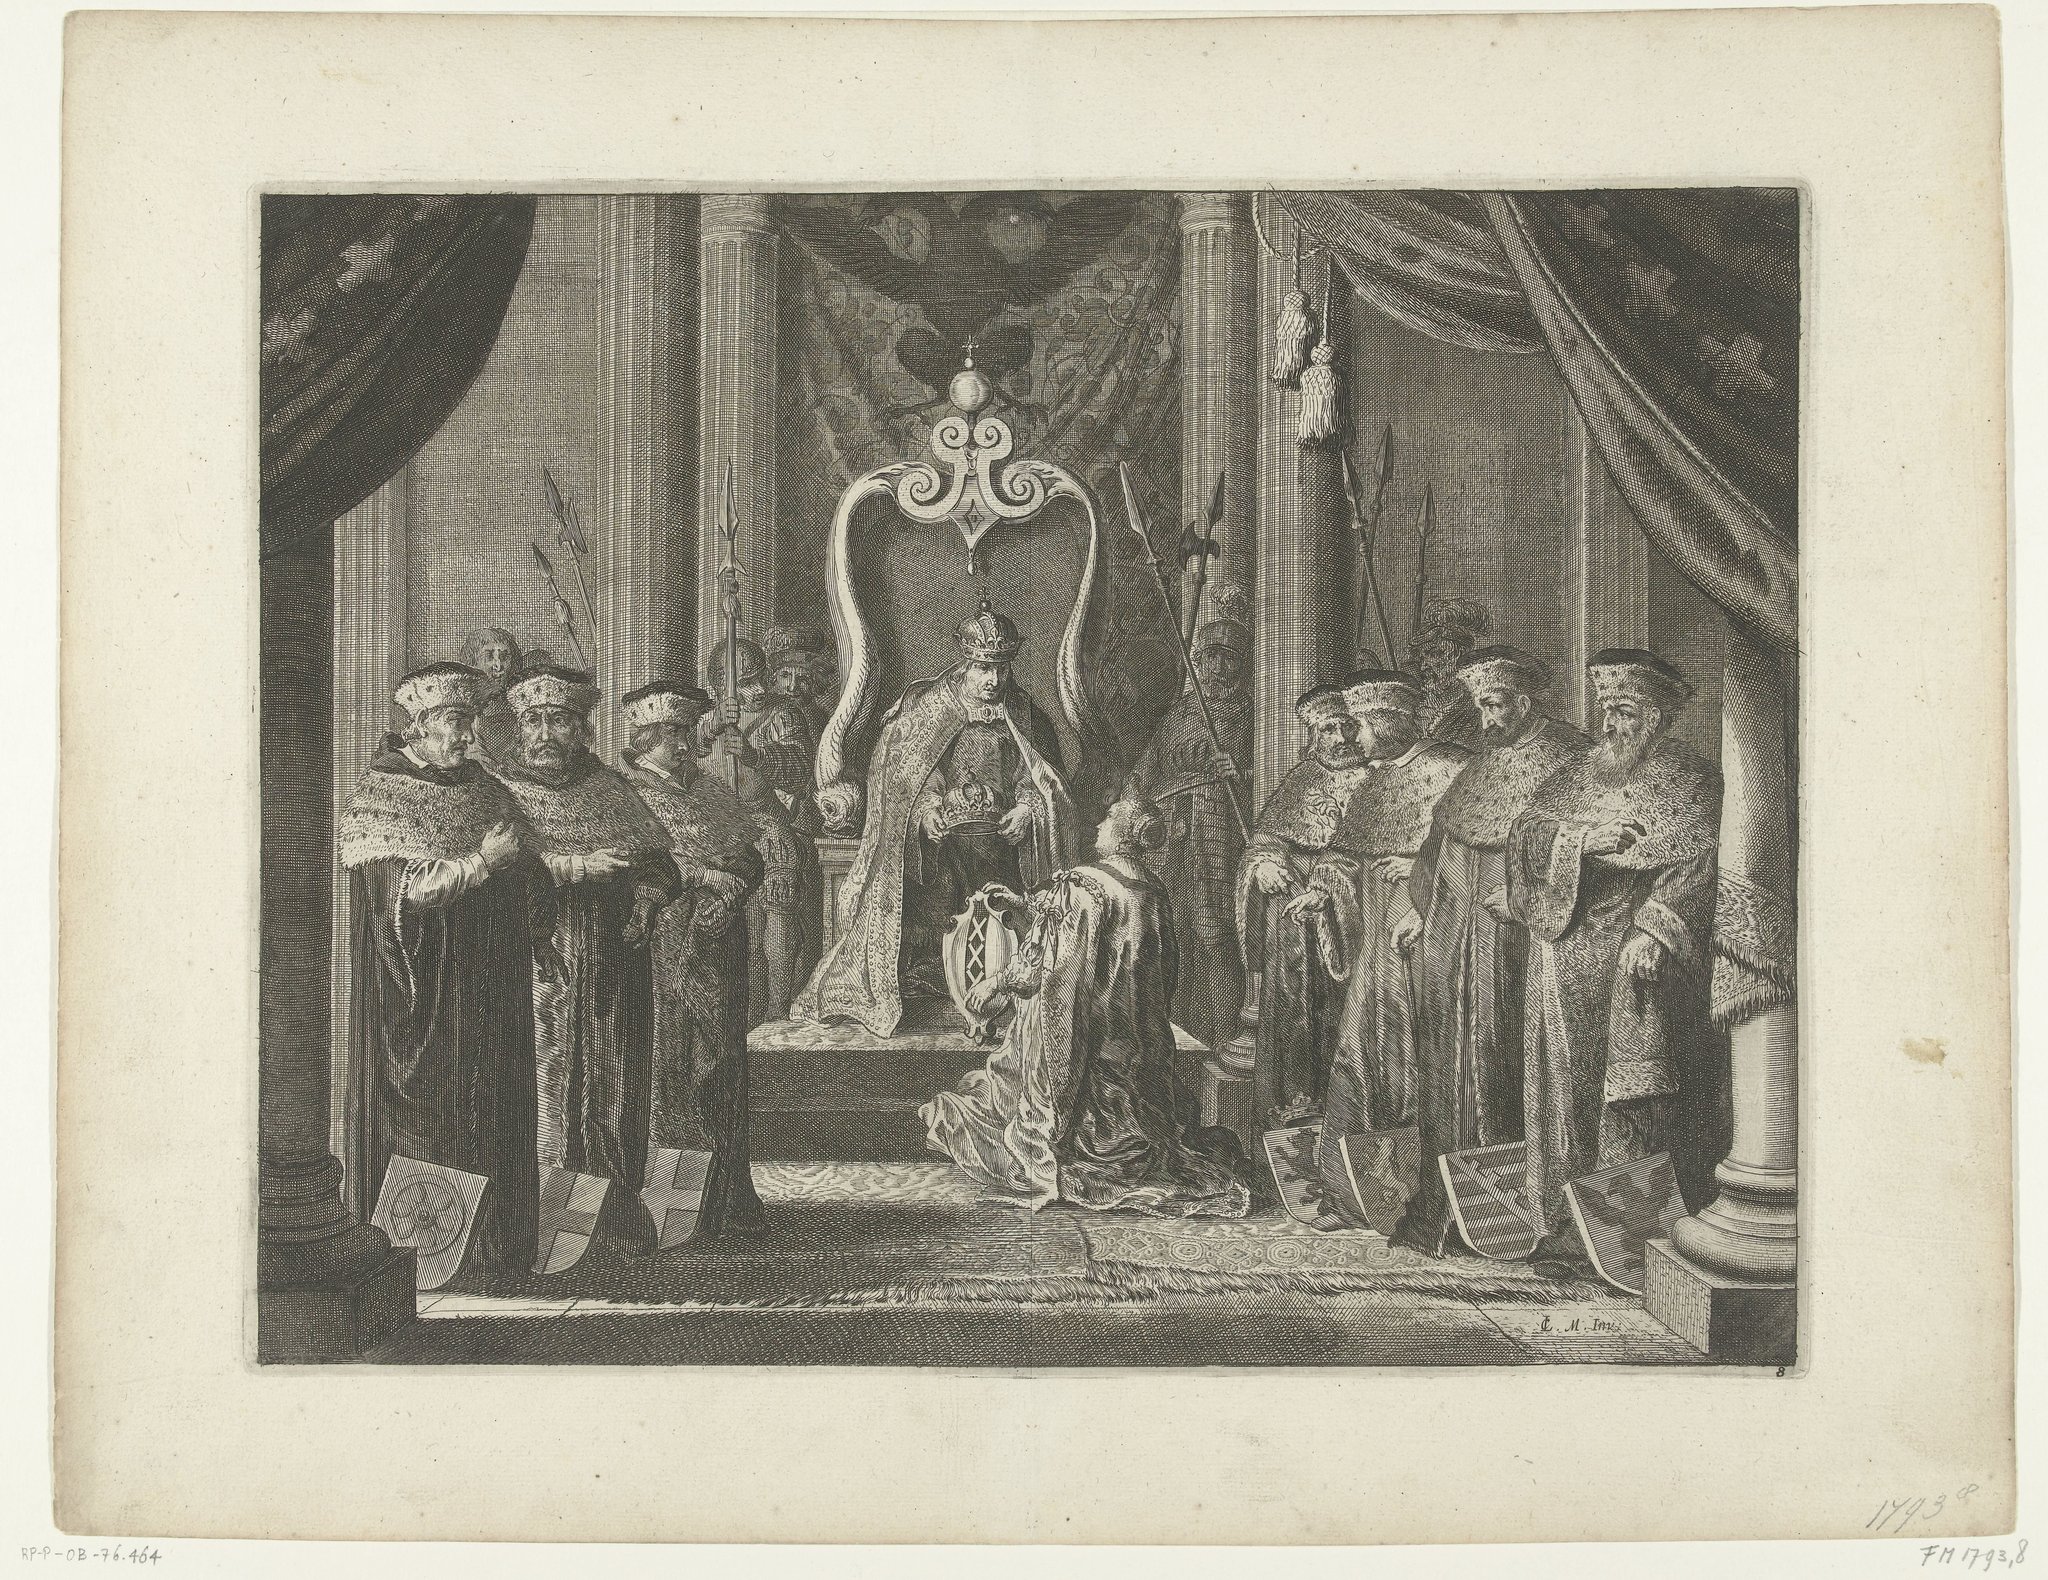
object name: book illustration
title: Keizer Maximiliaan I verleent de keizerskroon aan Amsterdam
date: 1638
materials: paper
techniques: engraving, etching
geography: amsterdam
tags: cologne, maria de' medici, maximilian i (holy roman emperor), 'tableau vivant', personification of a city, town-patron(ess), triumphal entry and public reception, pageant, 'entrée solennelle', 'joyeuse entrée', amsterdam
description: Prent ook gebruikt in:* Baerle, Caspar van. Medicea hospes, sive descriptio publicae gratulationis, qua Serenissimam, Augustissimamque Reginam, Mariam de Medicis (…). Amsterdam: Johannes en Cornelis Willemsz. Blaeu, 1638. En in: Baerle, Caspar van. Marie de Medicis, entrant dans Amsterdam : ou, histoire de la reception faicte à la Reyne Mere du Roy tres-Chrestien (…). Amsterdam: Johannes en Cornelis Willemsz. Blaeu, 1638. En in: Baerle, Caspar van en Joost van den Vondel. Blyde inkomst der allerdoorluchtighste koninginne, Maria de Medicis t' Amsterdam. Vertaelt uit het Latijn (…). Amsterdam: Johannes en Cornelis Willemsz. Blaeu, 1639. * Doorgaans zijn de prenten in de bovengenoemde publicaties rechtsonder genummerd (van de huidige prent is dat de derde bekende staat). Maar er zijn ook exemplaren waarin eerdere, ongenummerde, staten van de prenten (van de huidige prent de eerste en tweede bekende staat) zijn ingebonden.